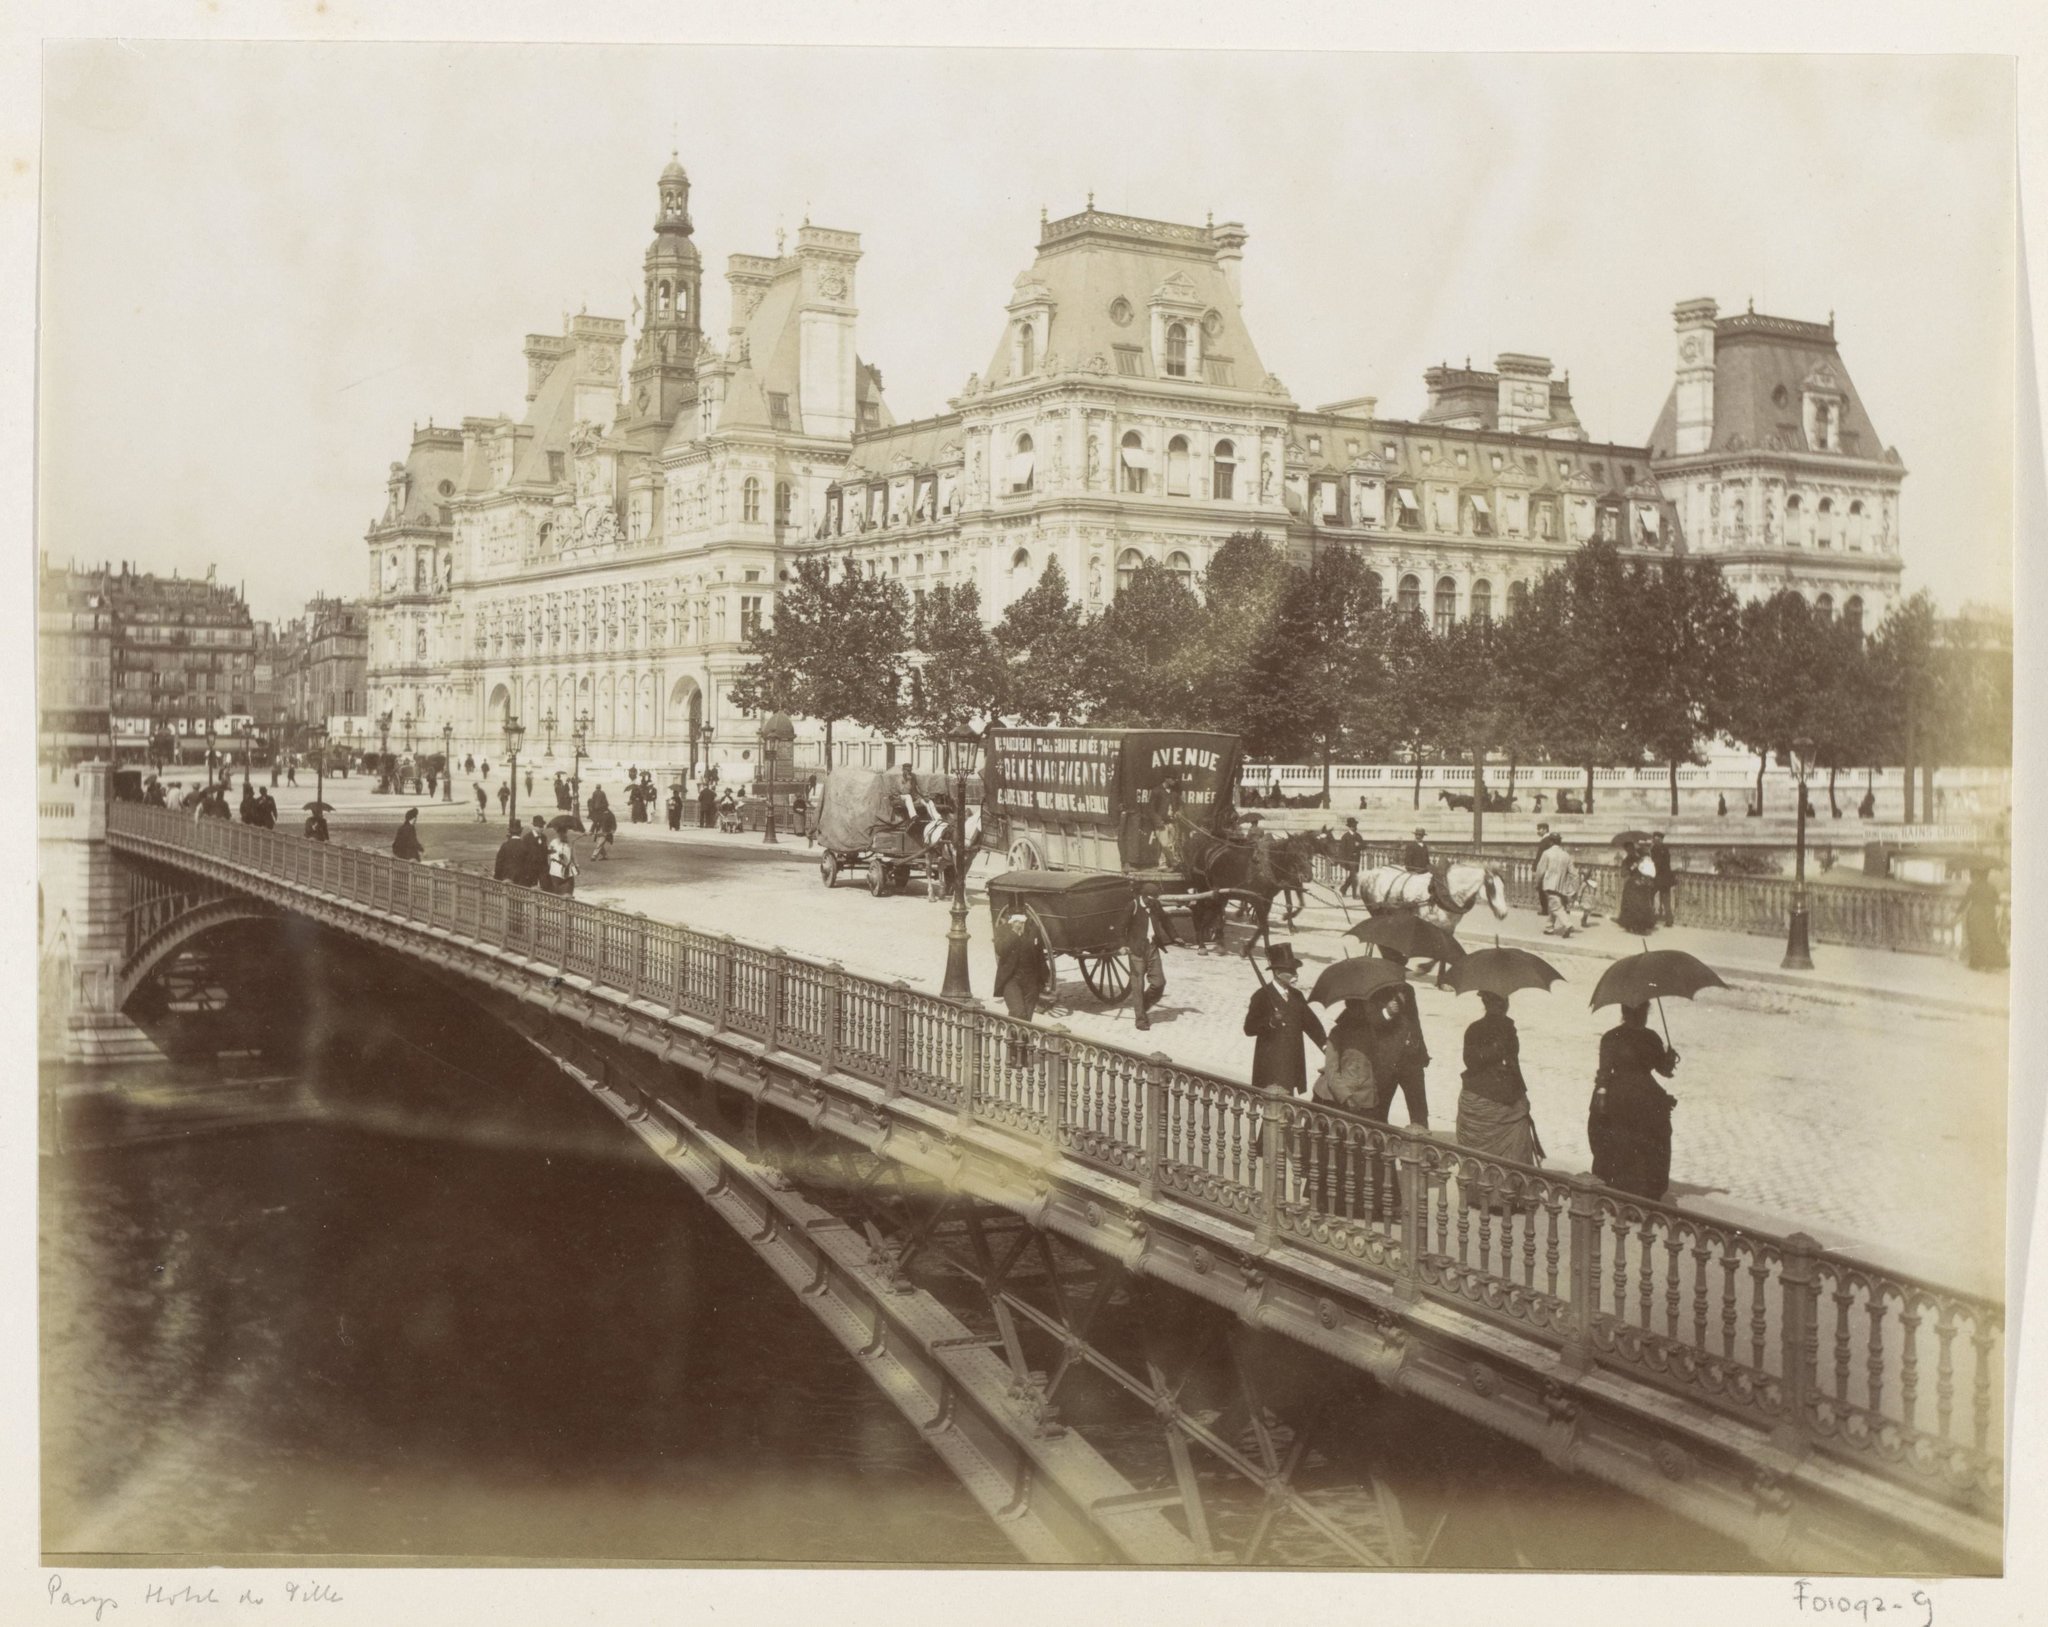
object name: photograph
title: Hôtel de Ville in Parijs met op de voorgrond de Pont d'Arcole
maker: Anonymous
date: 1880-1900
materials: cardboard, paper, photographic support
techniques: albumen print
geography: paris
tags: townhall, bridge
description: Onderdeel van Reisalbum met foto's van bezienswaardigheden in België en Frankrijk.